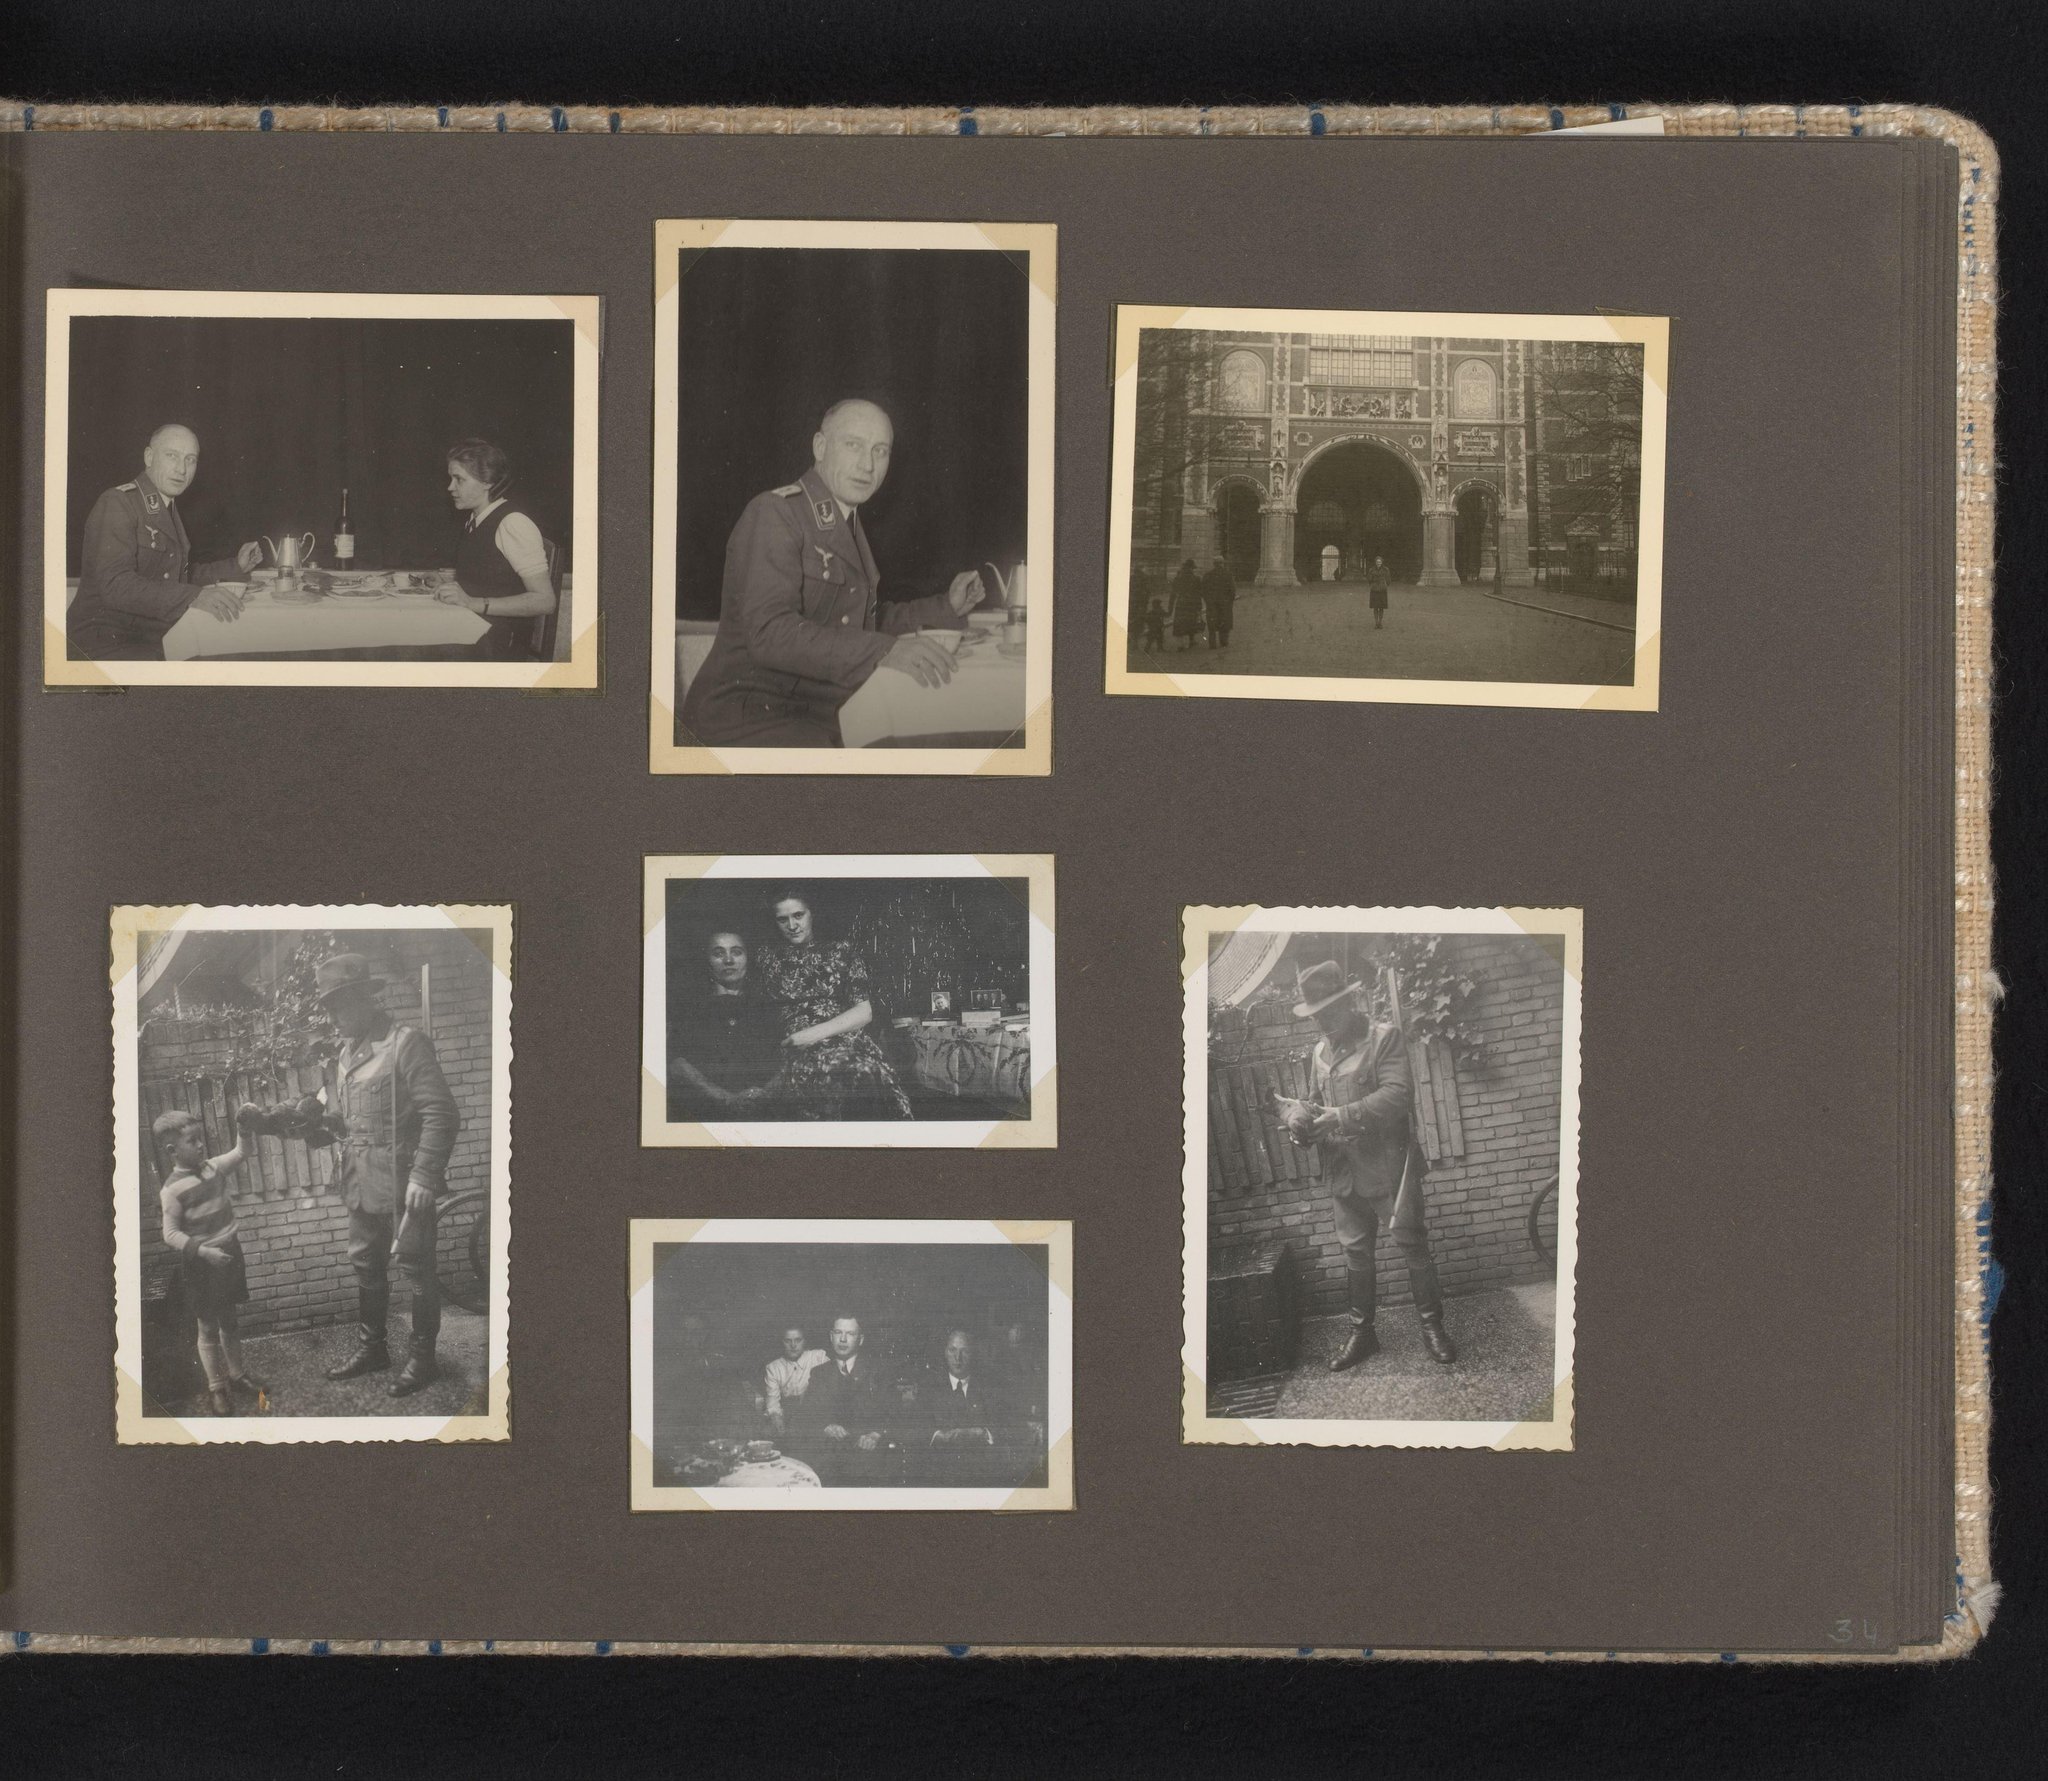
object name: photograph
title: Diverse onderwerpen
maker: Anonymous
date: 1941-1943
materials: cardboard, photographic support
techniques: gelatin silver print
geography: netherlands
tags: leave ~ the soldier off duty, occupation ~ war, netherlands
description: Albumblad met zeven foto's van diverse onderwerpen, waaronder familie en vrienden en voor het Rijksmuseum te Amsterdam. Onderdeel van het fotoalbum Abrechnungsintendantur van de Wehrmacht 1941-1943.